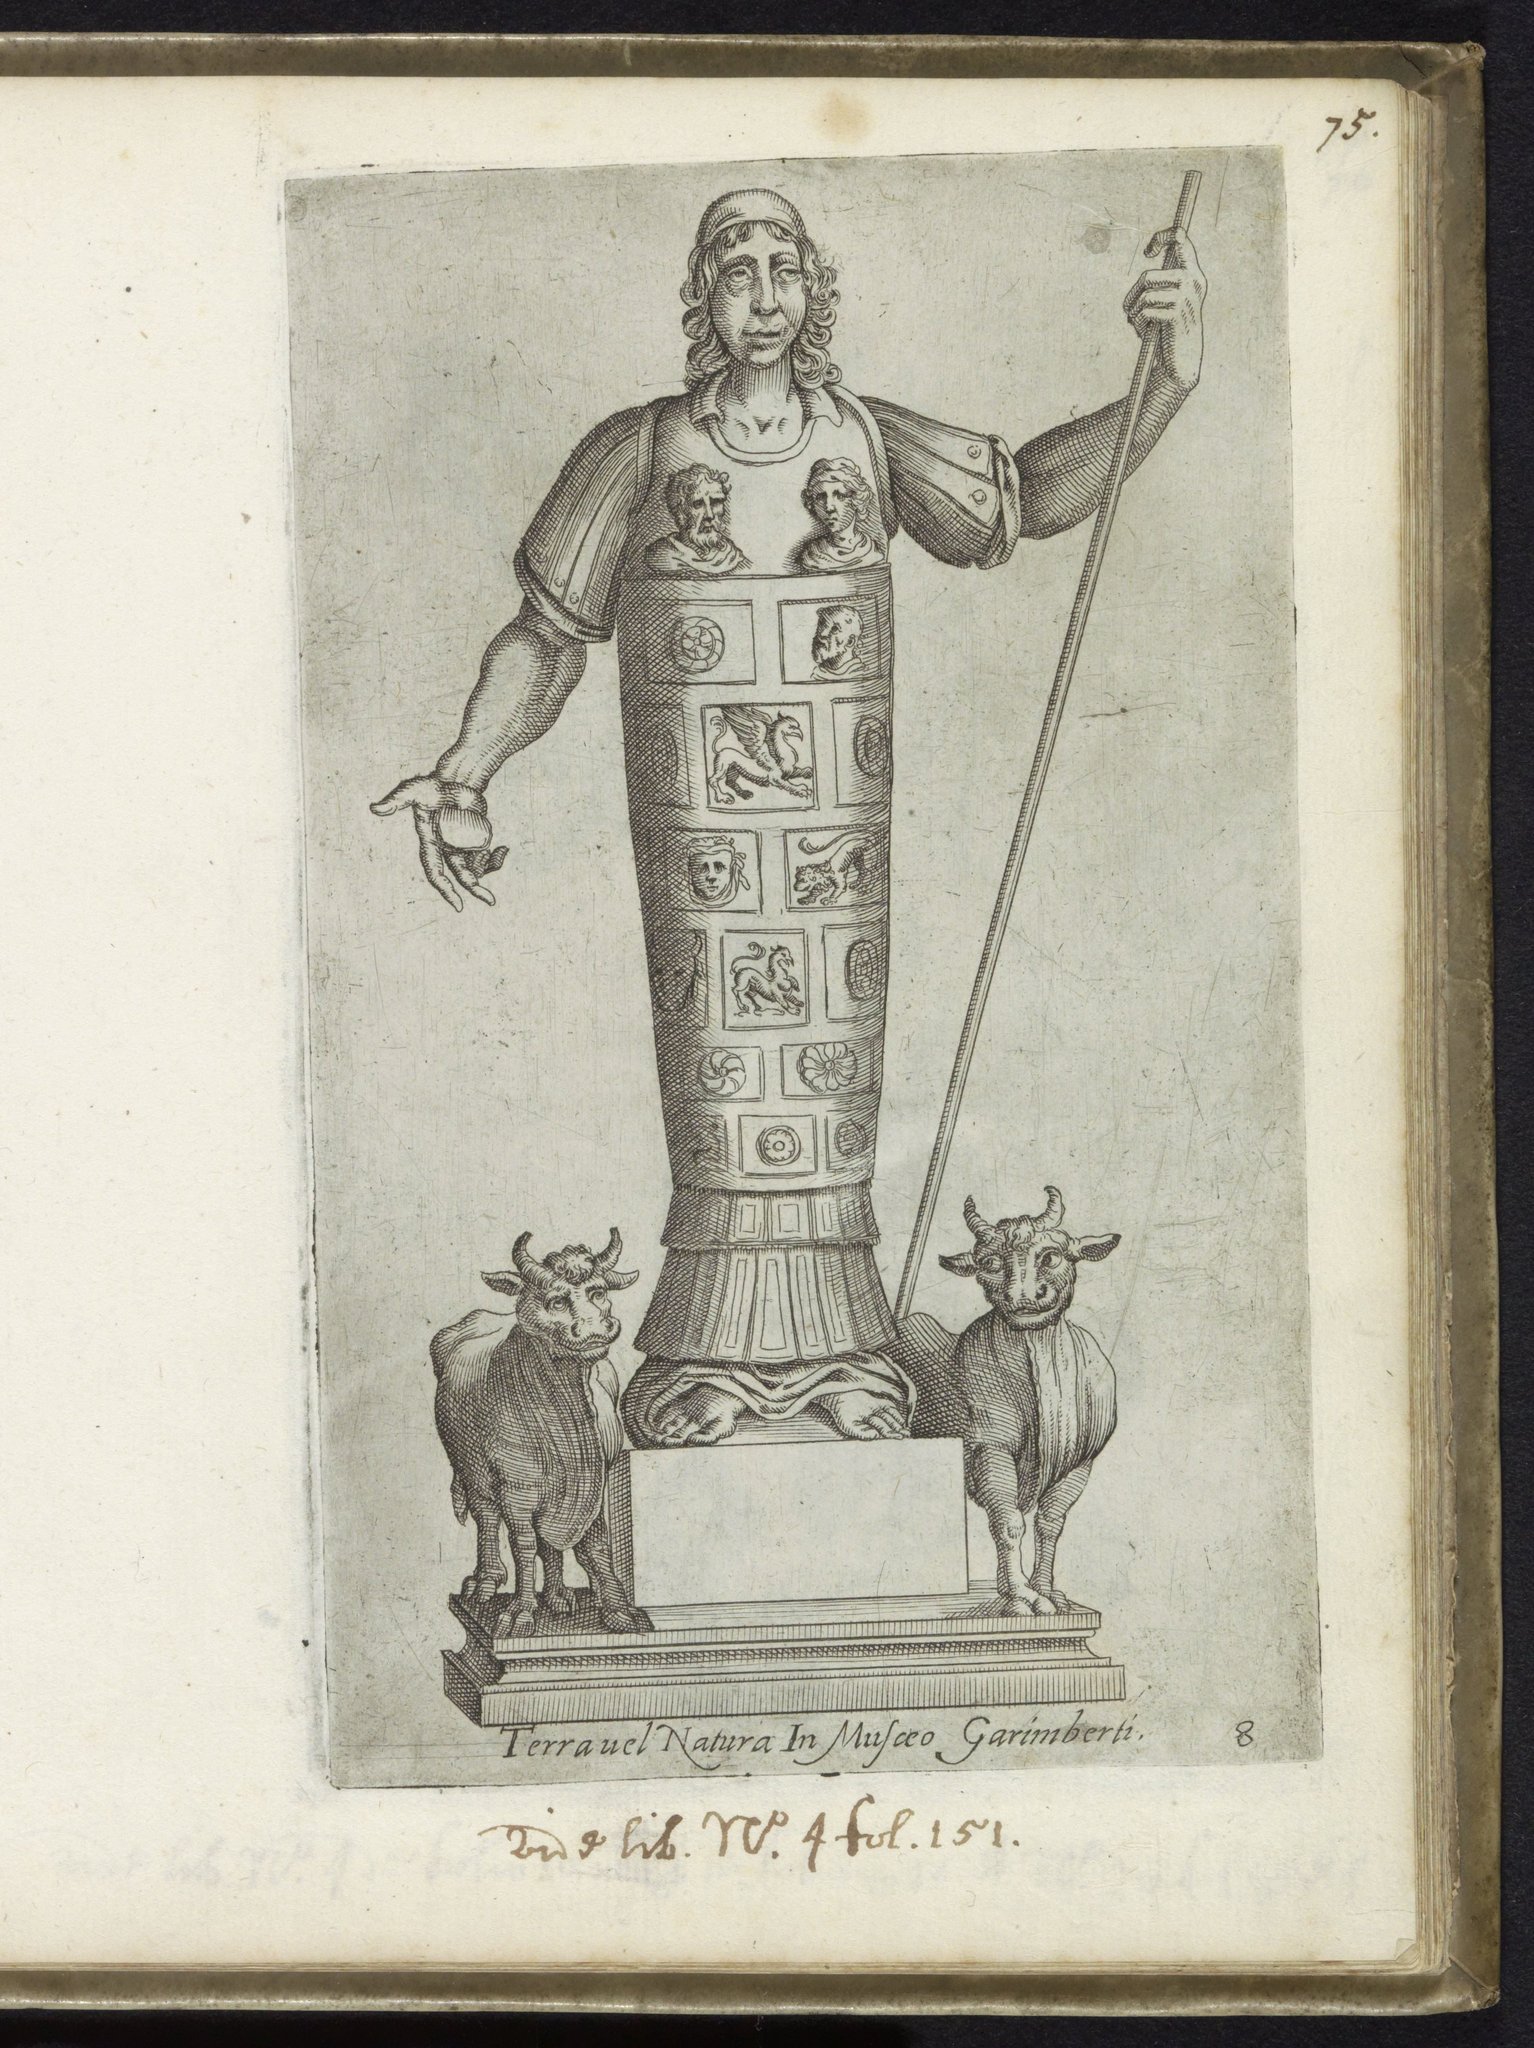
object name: album leaf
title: Sculptuur van een herder tussen twee ossen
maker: Anonymous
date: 1600-1699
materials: paper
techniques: engraving, etching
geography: italy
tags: herding, herdsman, herdswoman, shepherd, shepherdess, cowherd, etc., piece of sculpture, reproduction of a piece of sculpture, ox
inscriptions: number: ‘75’, inscription: ‘Ende lib. No. 4 fol. 151.’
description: Deze prent maakt deel uit van een reeks van ten minste 50 prenten van sculpturen uit de oudheid.